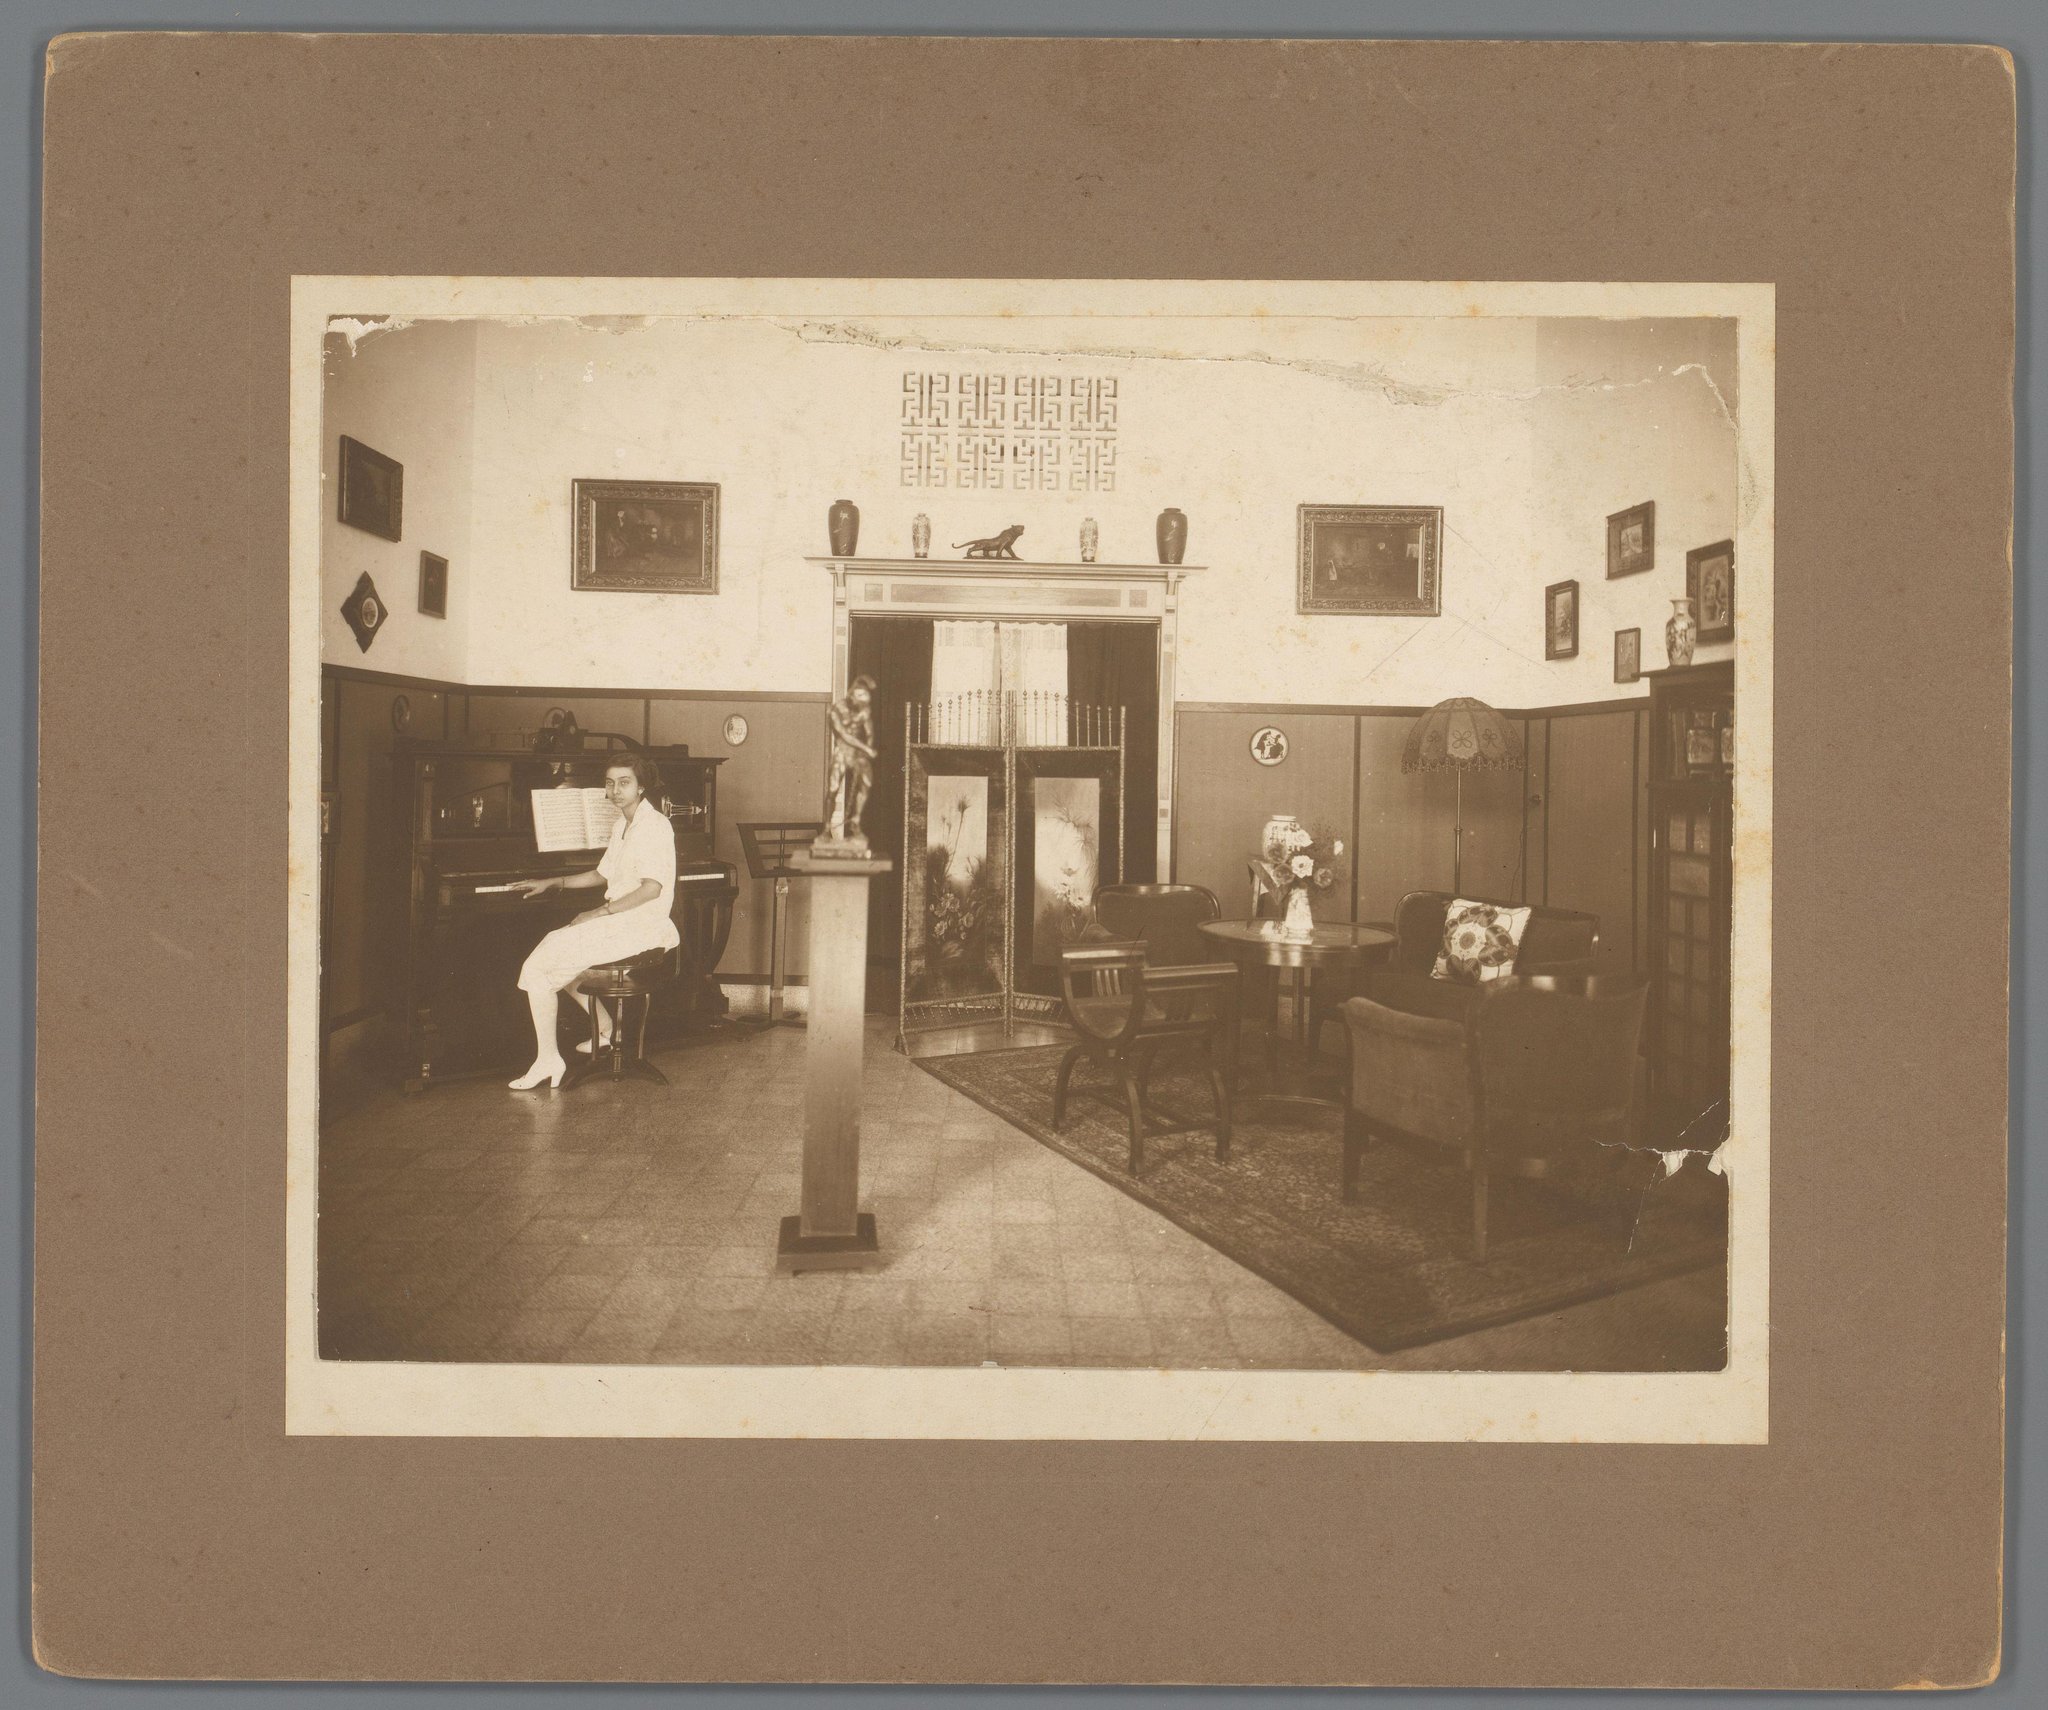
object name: photograph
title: Ons Salon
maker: Anonymous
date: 1923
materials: paper, cardboard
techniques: gelatin silver print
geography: surabaya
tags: living-room, parlour, sitting-room, surabaya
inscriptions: inscription: ‘Ons Salon. S'baia, 20/5 '23/ II’